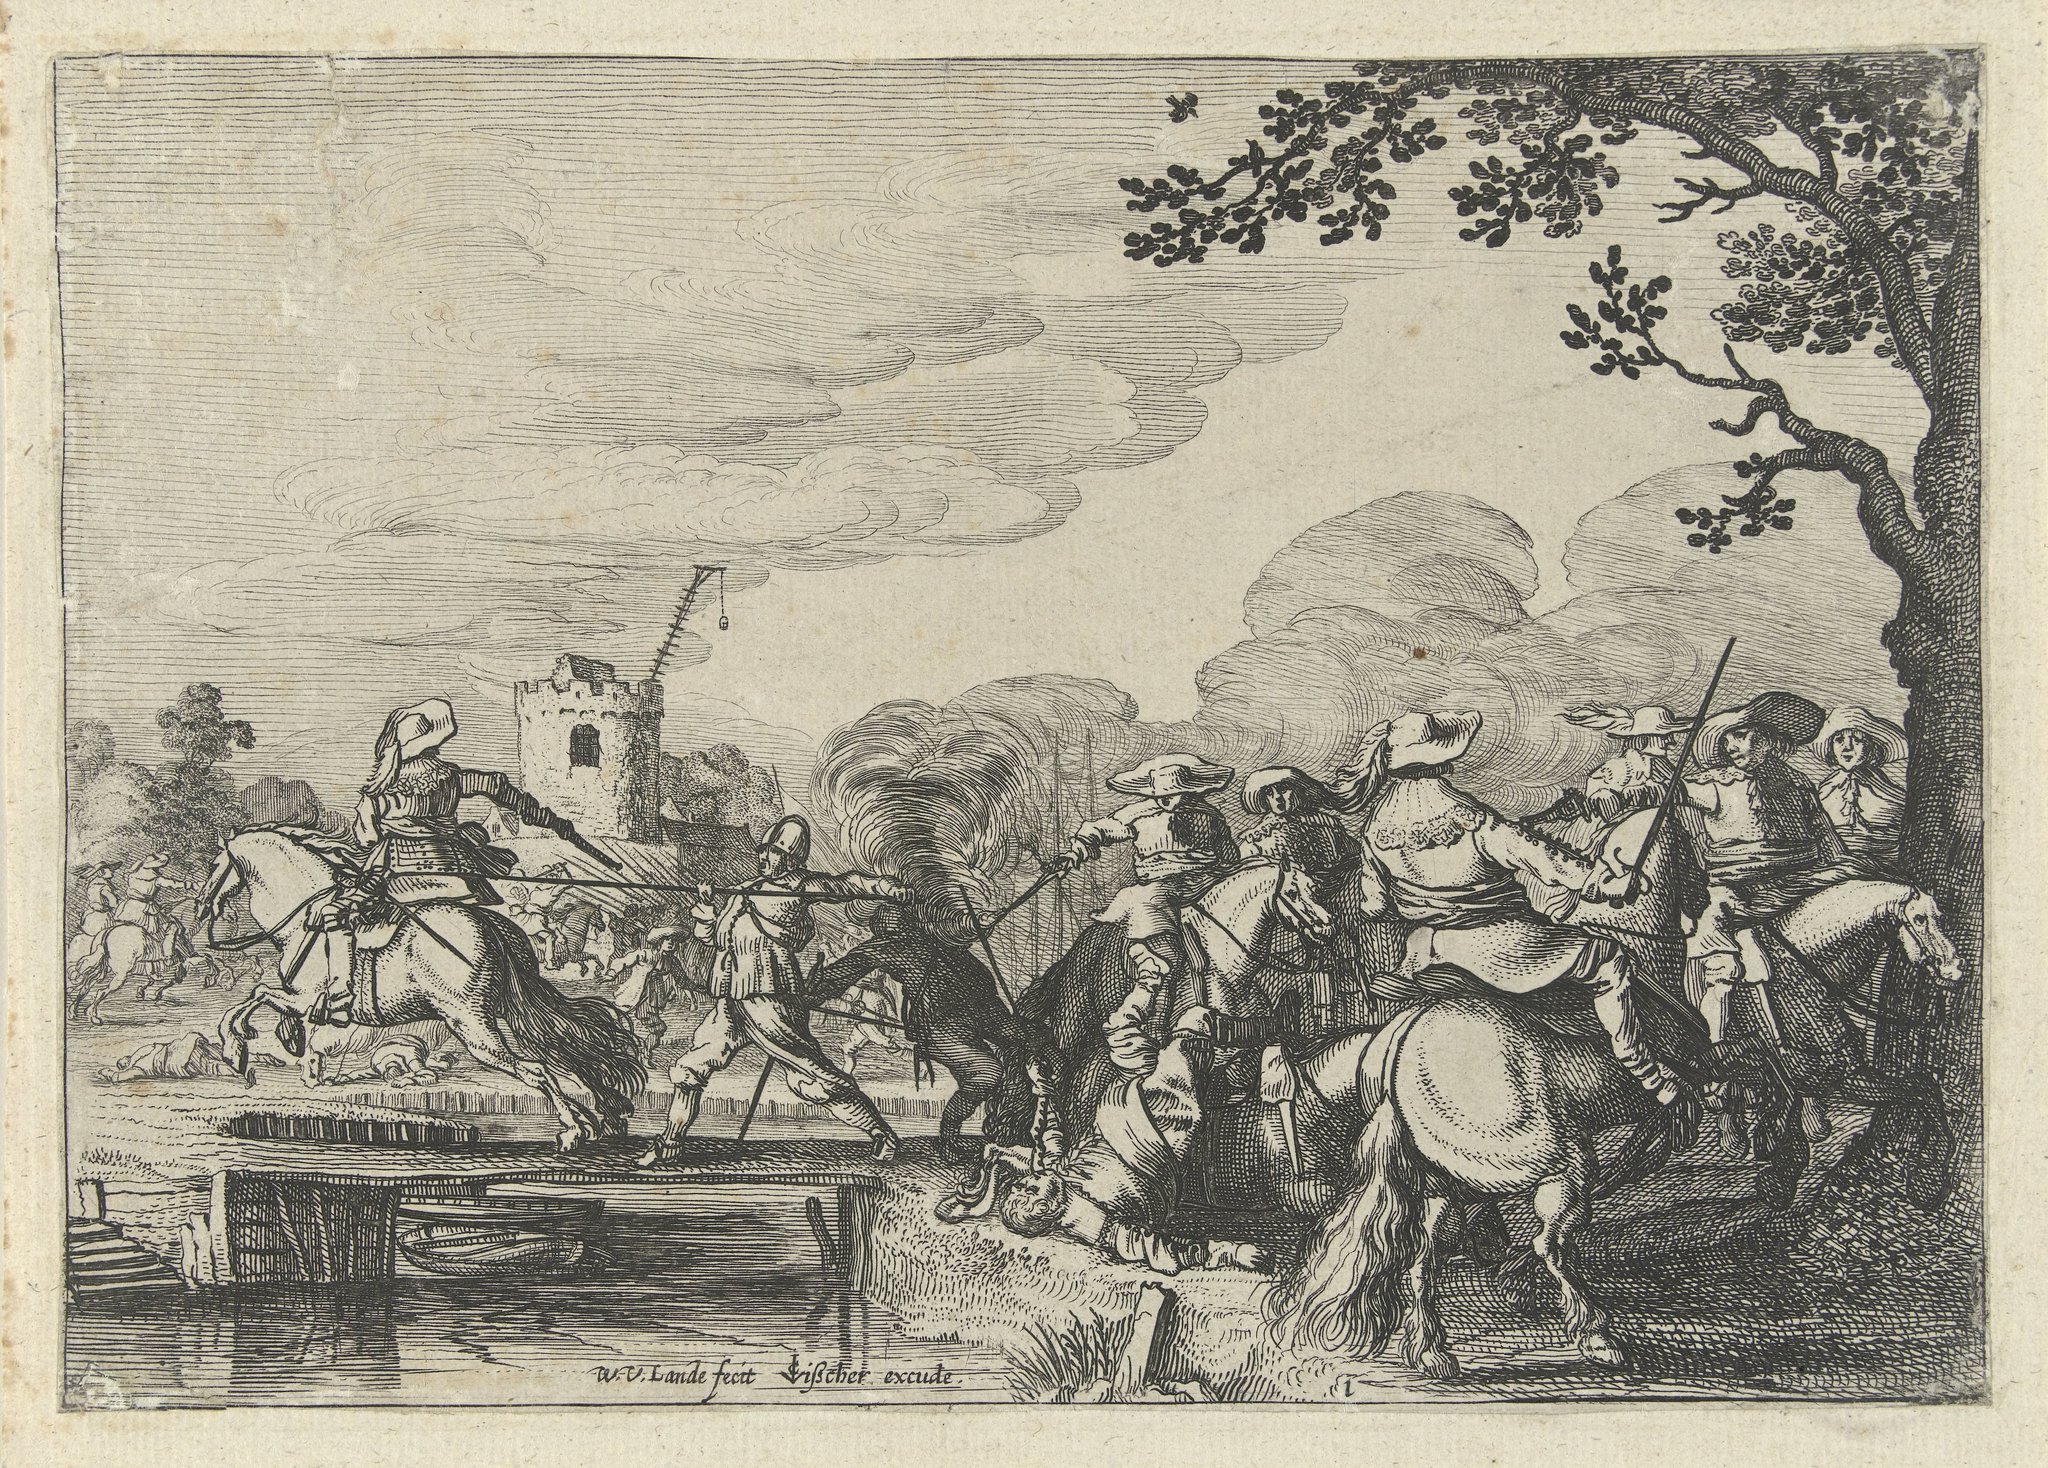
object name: print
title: Ruitergevecht bij een houten brug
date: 1635-1652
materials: paper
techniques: etching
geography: amsterdam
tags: riding a horse, ass, or mule; rider, horseman, battle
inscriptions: collector's mark: Lugt 240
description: Ruitergevecht bij een houten brug met schietende figuren. De prent maakt deel uit van een zesdelige serie prenten met ruitergevechten. Prent rechts van het midden genummerd: 1.